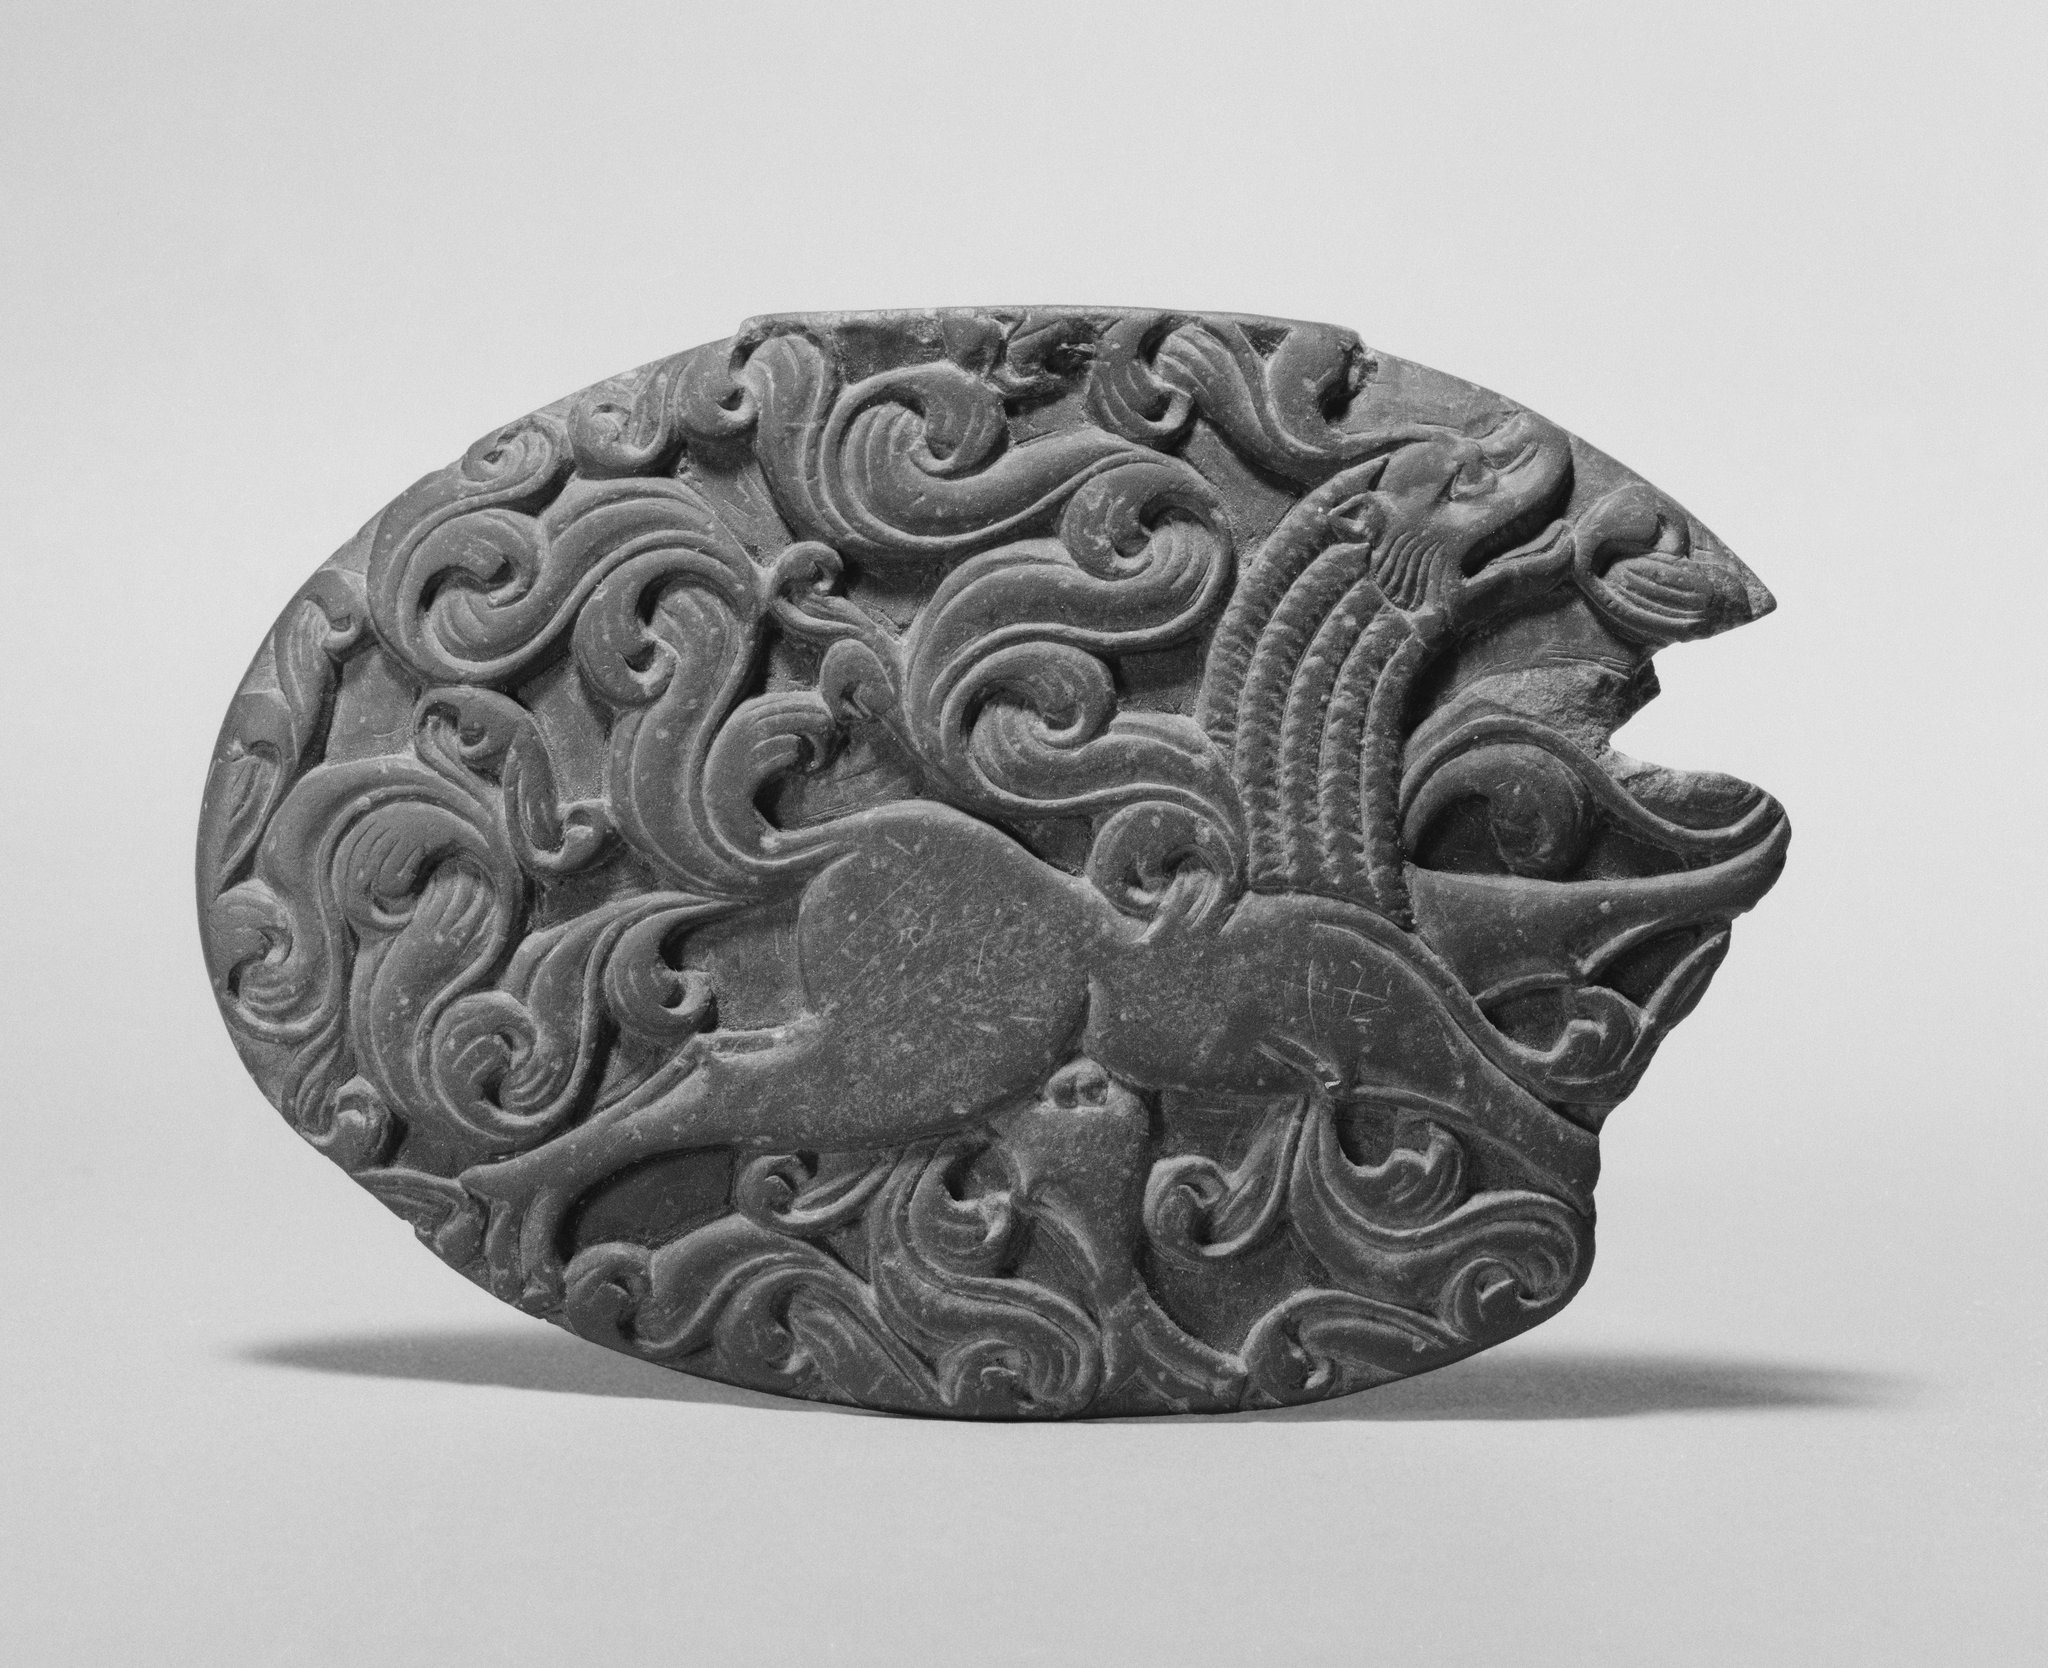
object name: box with lid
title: Box Lid with a Winged Lion and Remnant of an Iron Hinge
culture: gandhara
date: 401-500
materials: stone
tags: gandhara,lions